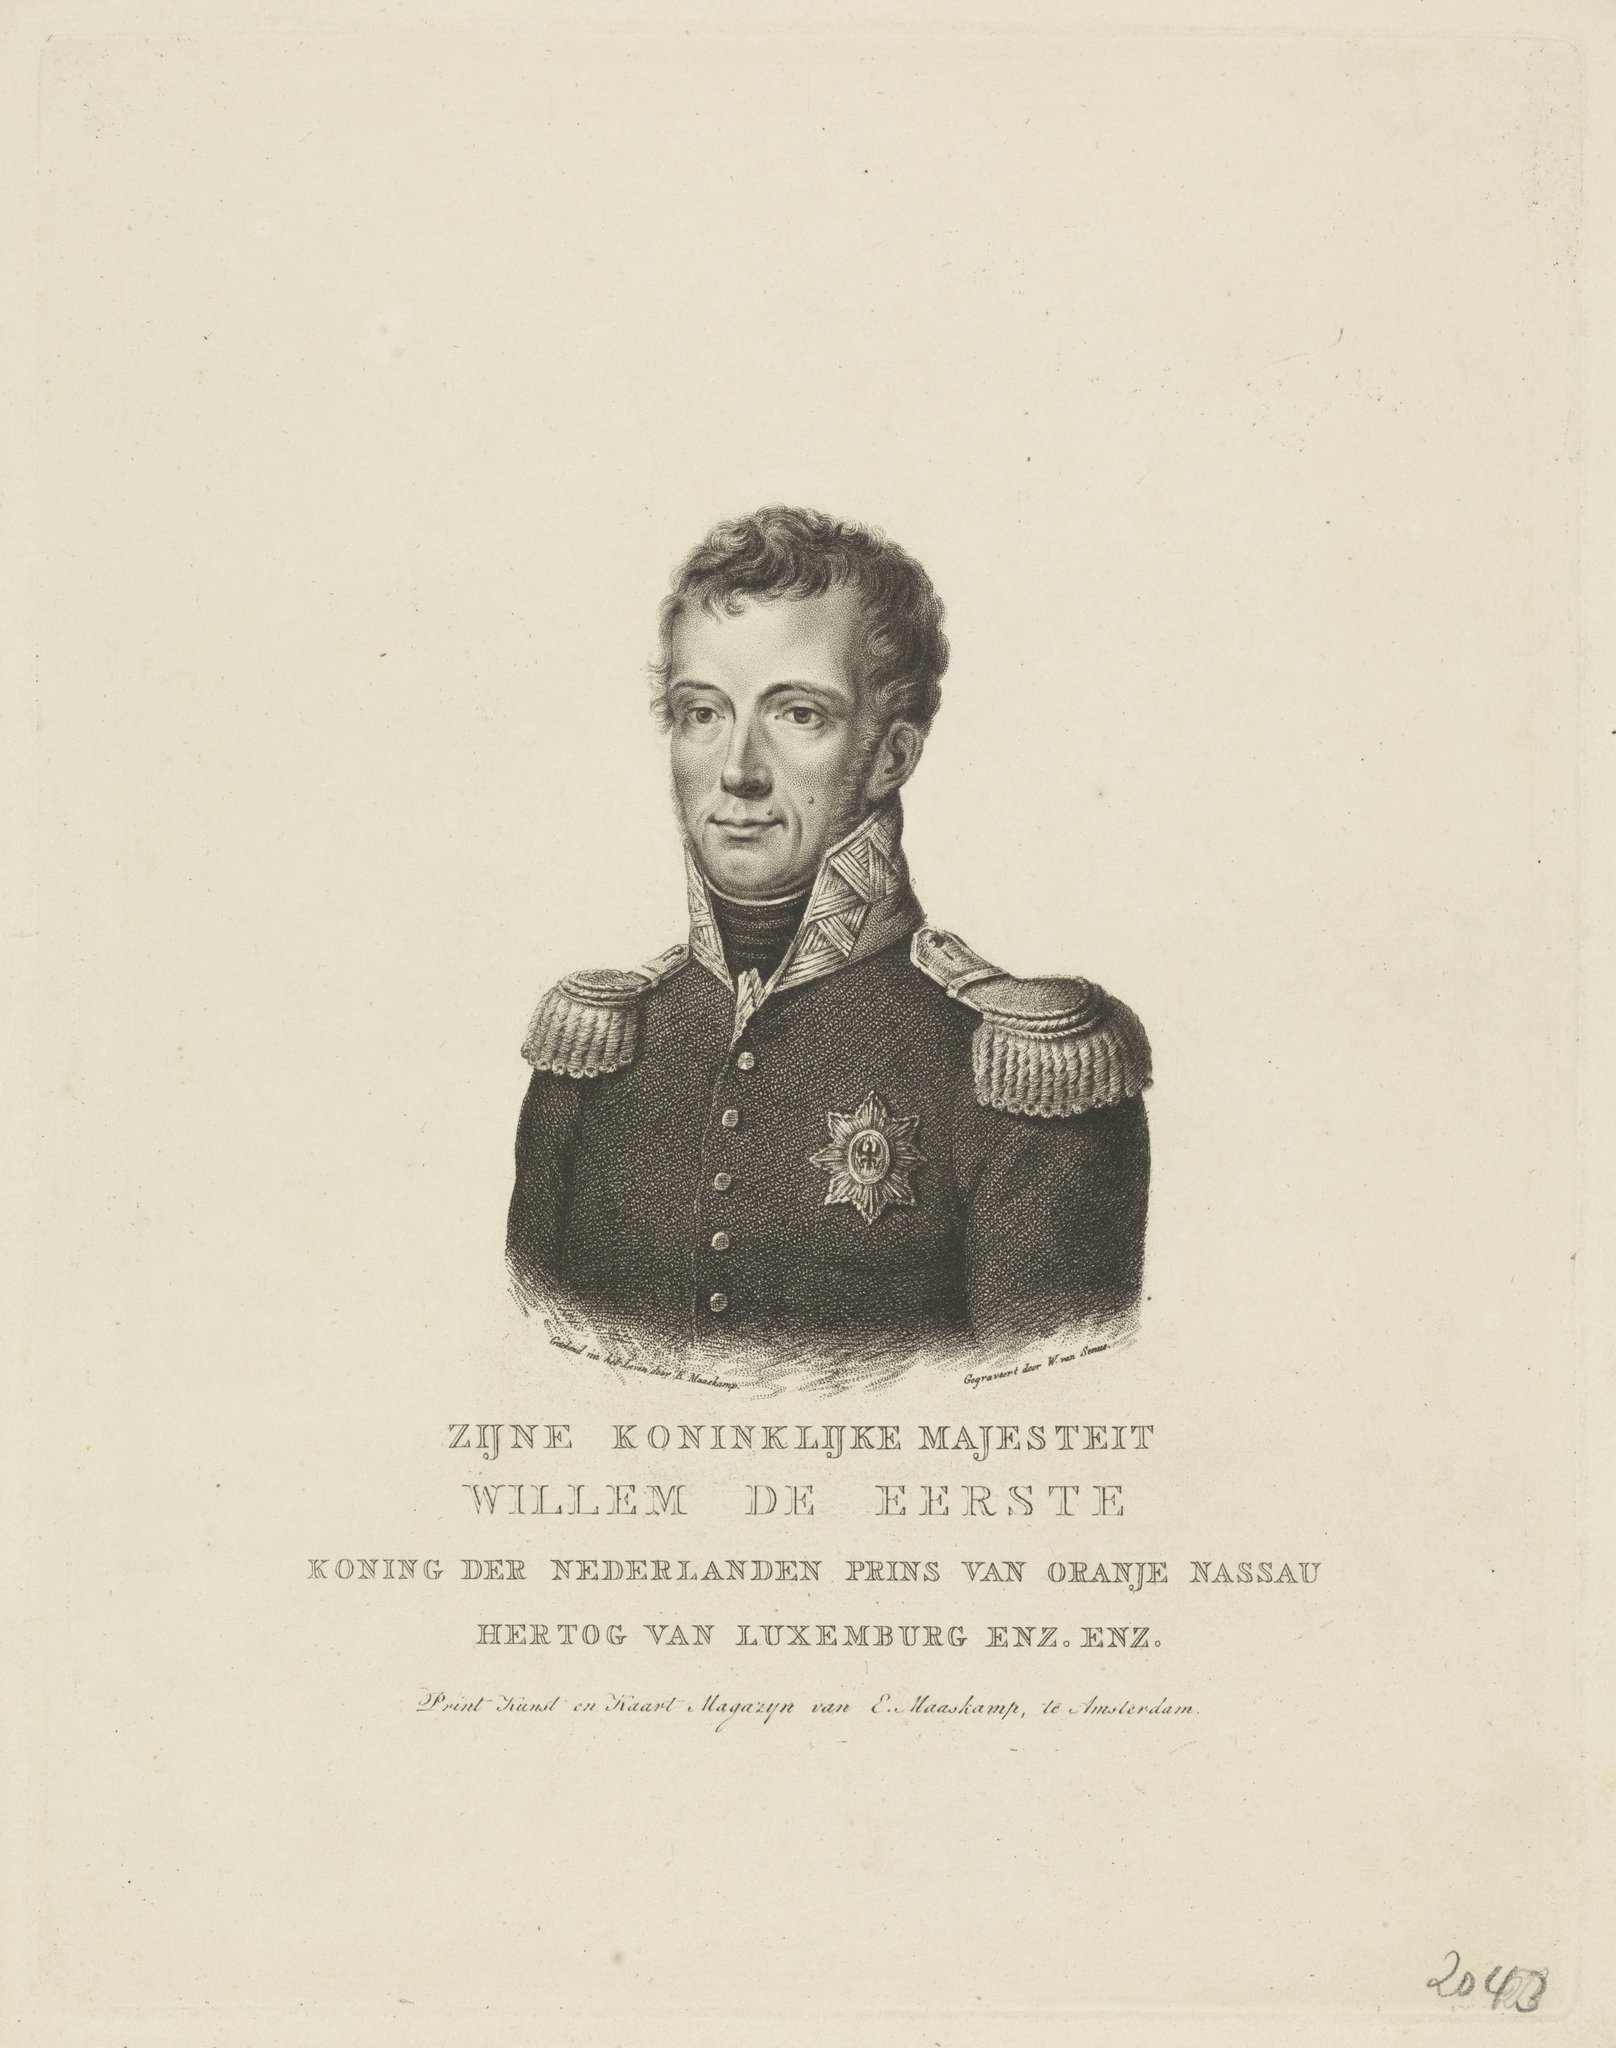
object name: print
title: Portret van Willem I Frederik, koning der Nederlanden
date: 1815-1834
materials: paper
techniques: engraving, etching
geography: amsterdam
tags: the hague, william i of the netherlands, knighthood order (with name) - insignia of a knighthood order, e.g.: badge, chain (with name of order)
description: De hier vermelde titel verwijst naar de hoogst verkregen titel van de geportretteerde, niet per se naar de titel die de geportretteerde op deze voorstelling draagt.